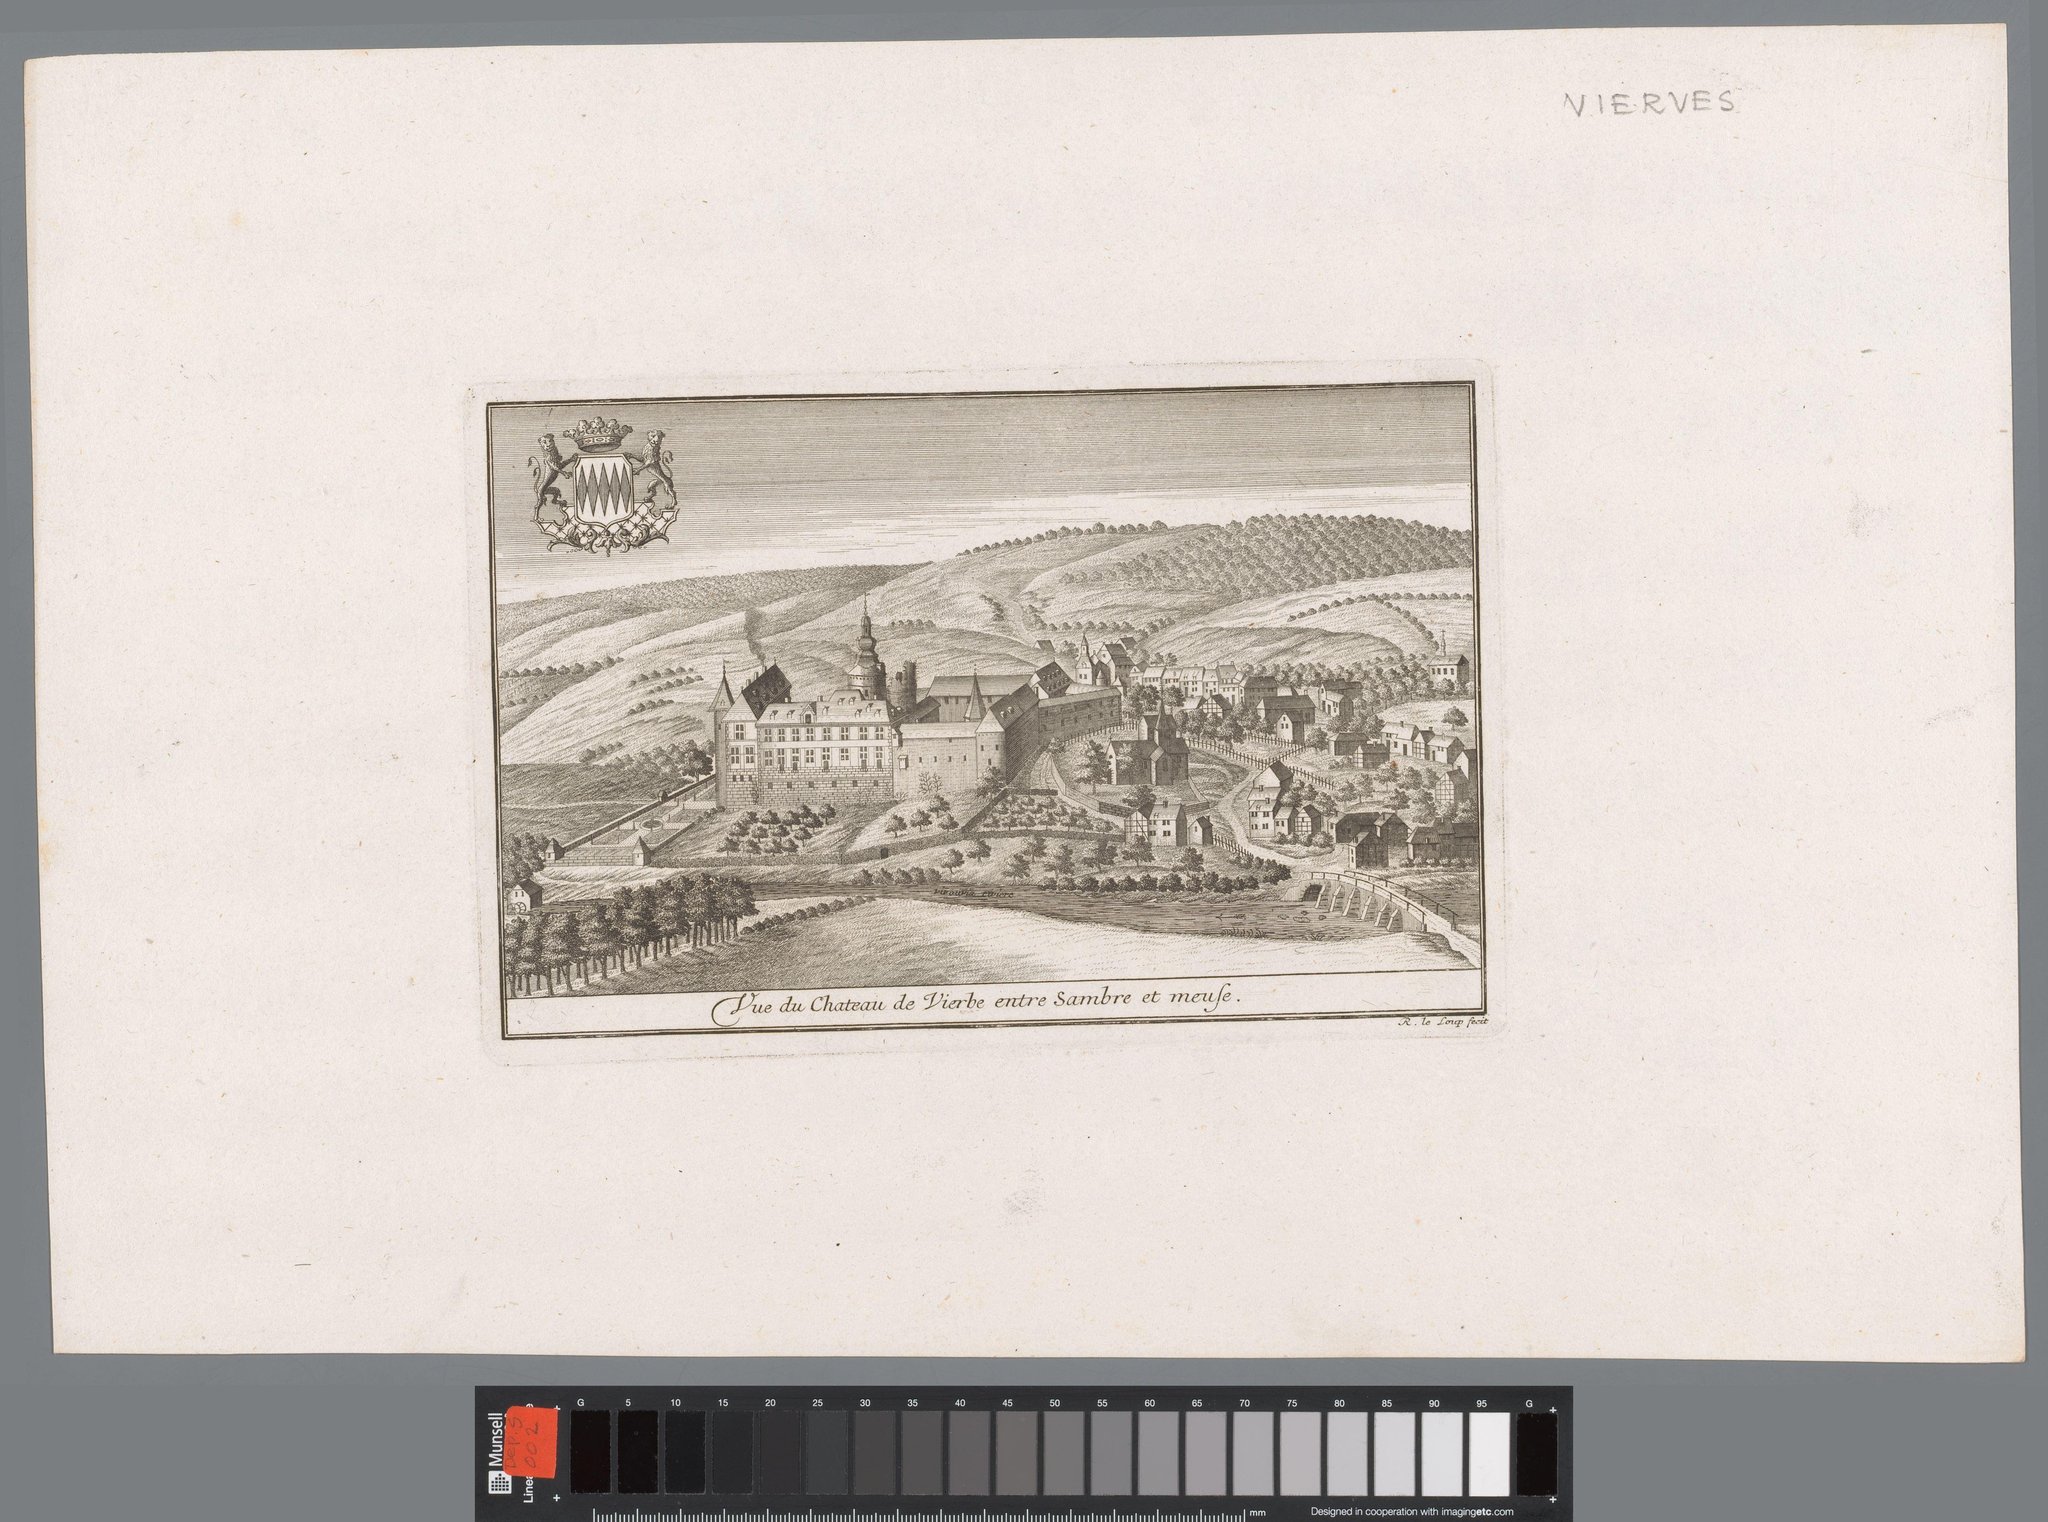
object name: print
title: Gezicht op het kasteel van Vierves-sur-Viroin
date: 1738-1744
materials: paper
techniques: engraving, etching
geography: liège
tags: castle, landscape with tower or castle, namur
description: Prent uit: Johanne de Saumery, Alexandre de et al. Les délices du païs de Liège, ou description géographique, topographique et chorographique des monumes sacrés et profanes (...). 5 dln. Luik: Everard Kints, 1738-1744, dl. 2, p. 291.